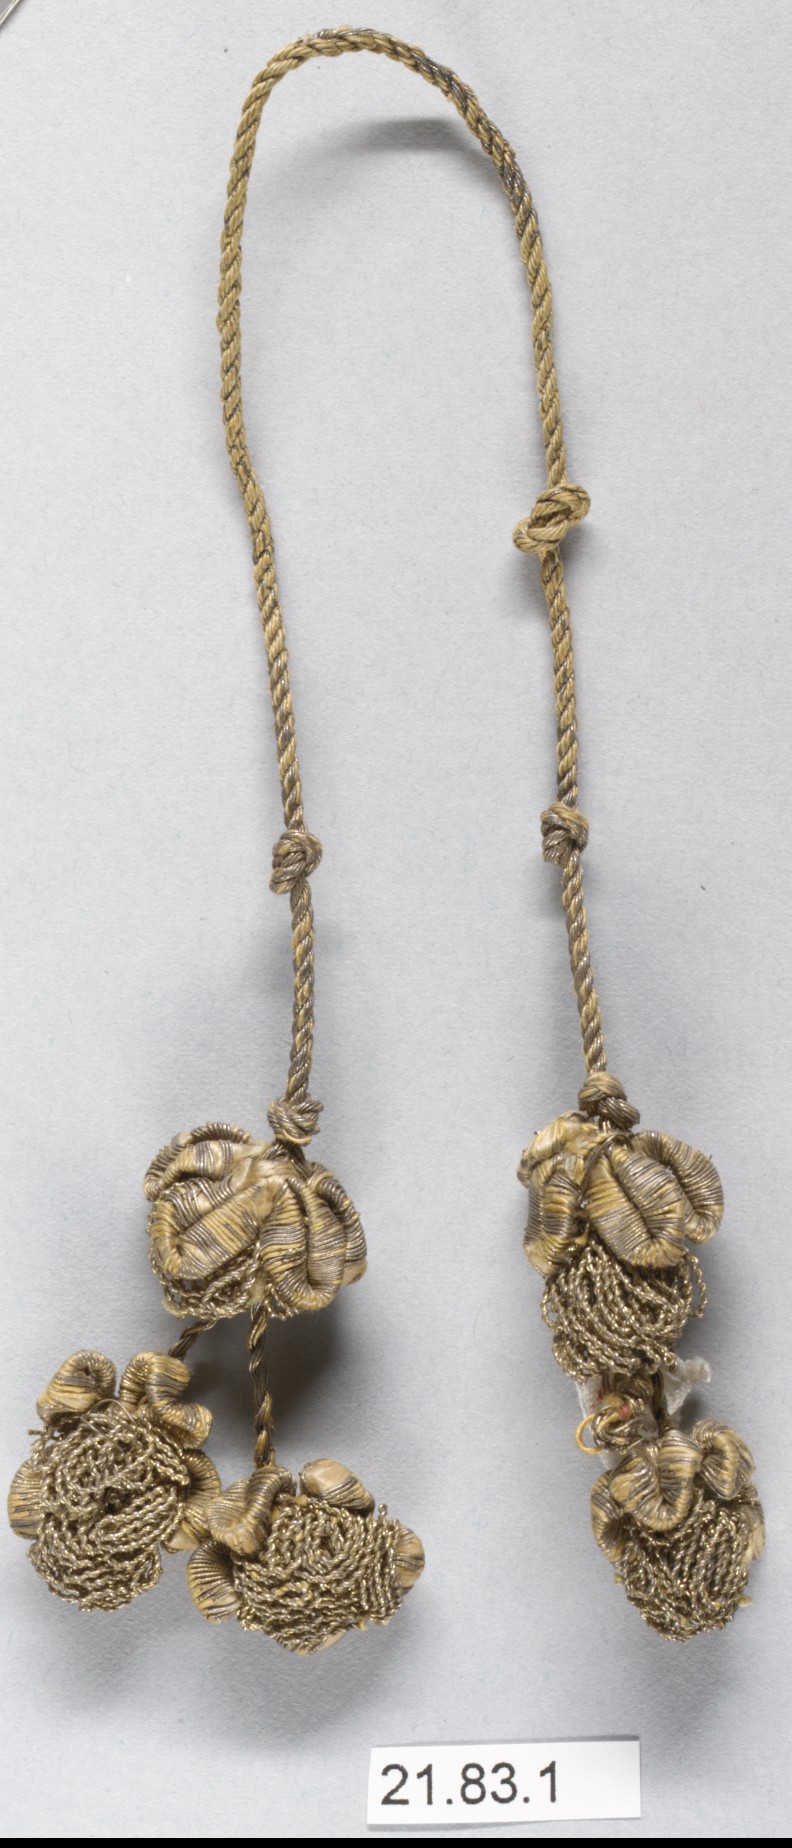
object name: tassel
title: Pair of tassels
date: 1601-1700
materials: metal thread, silk